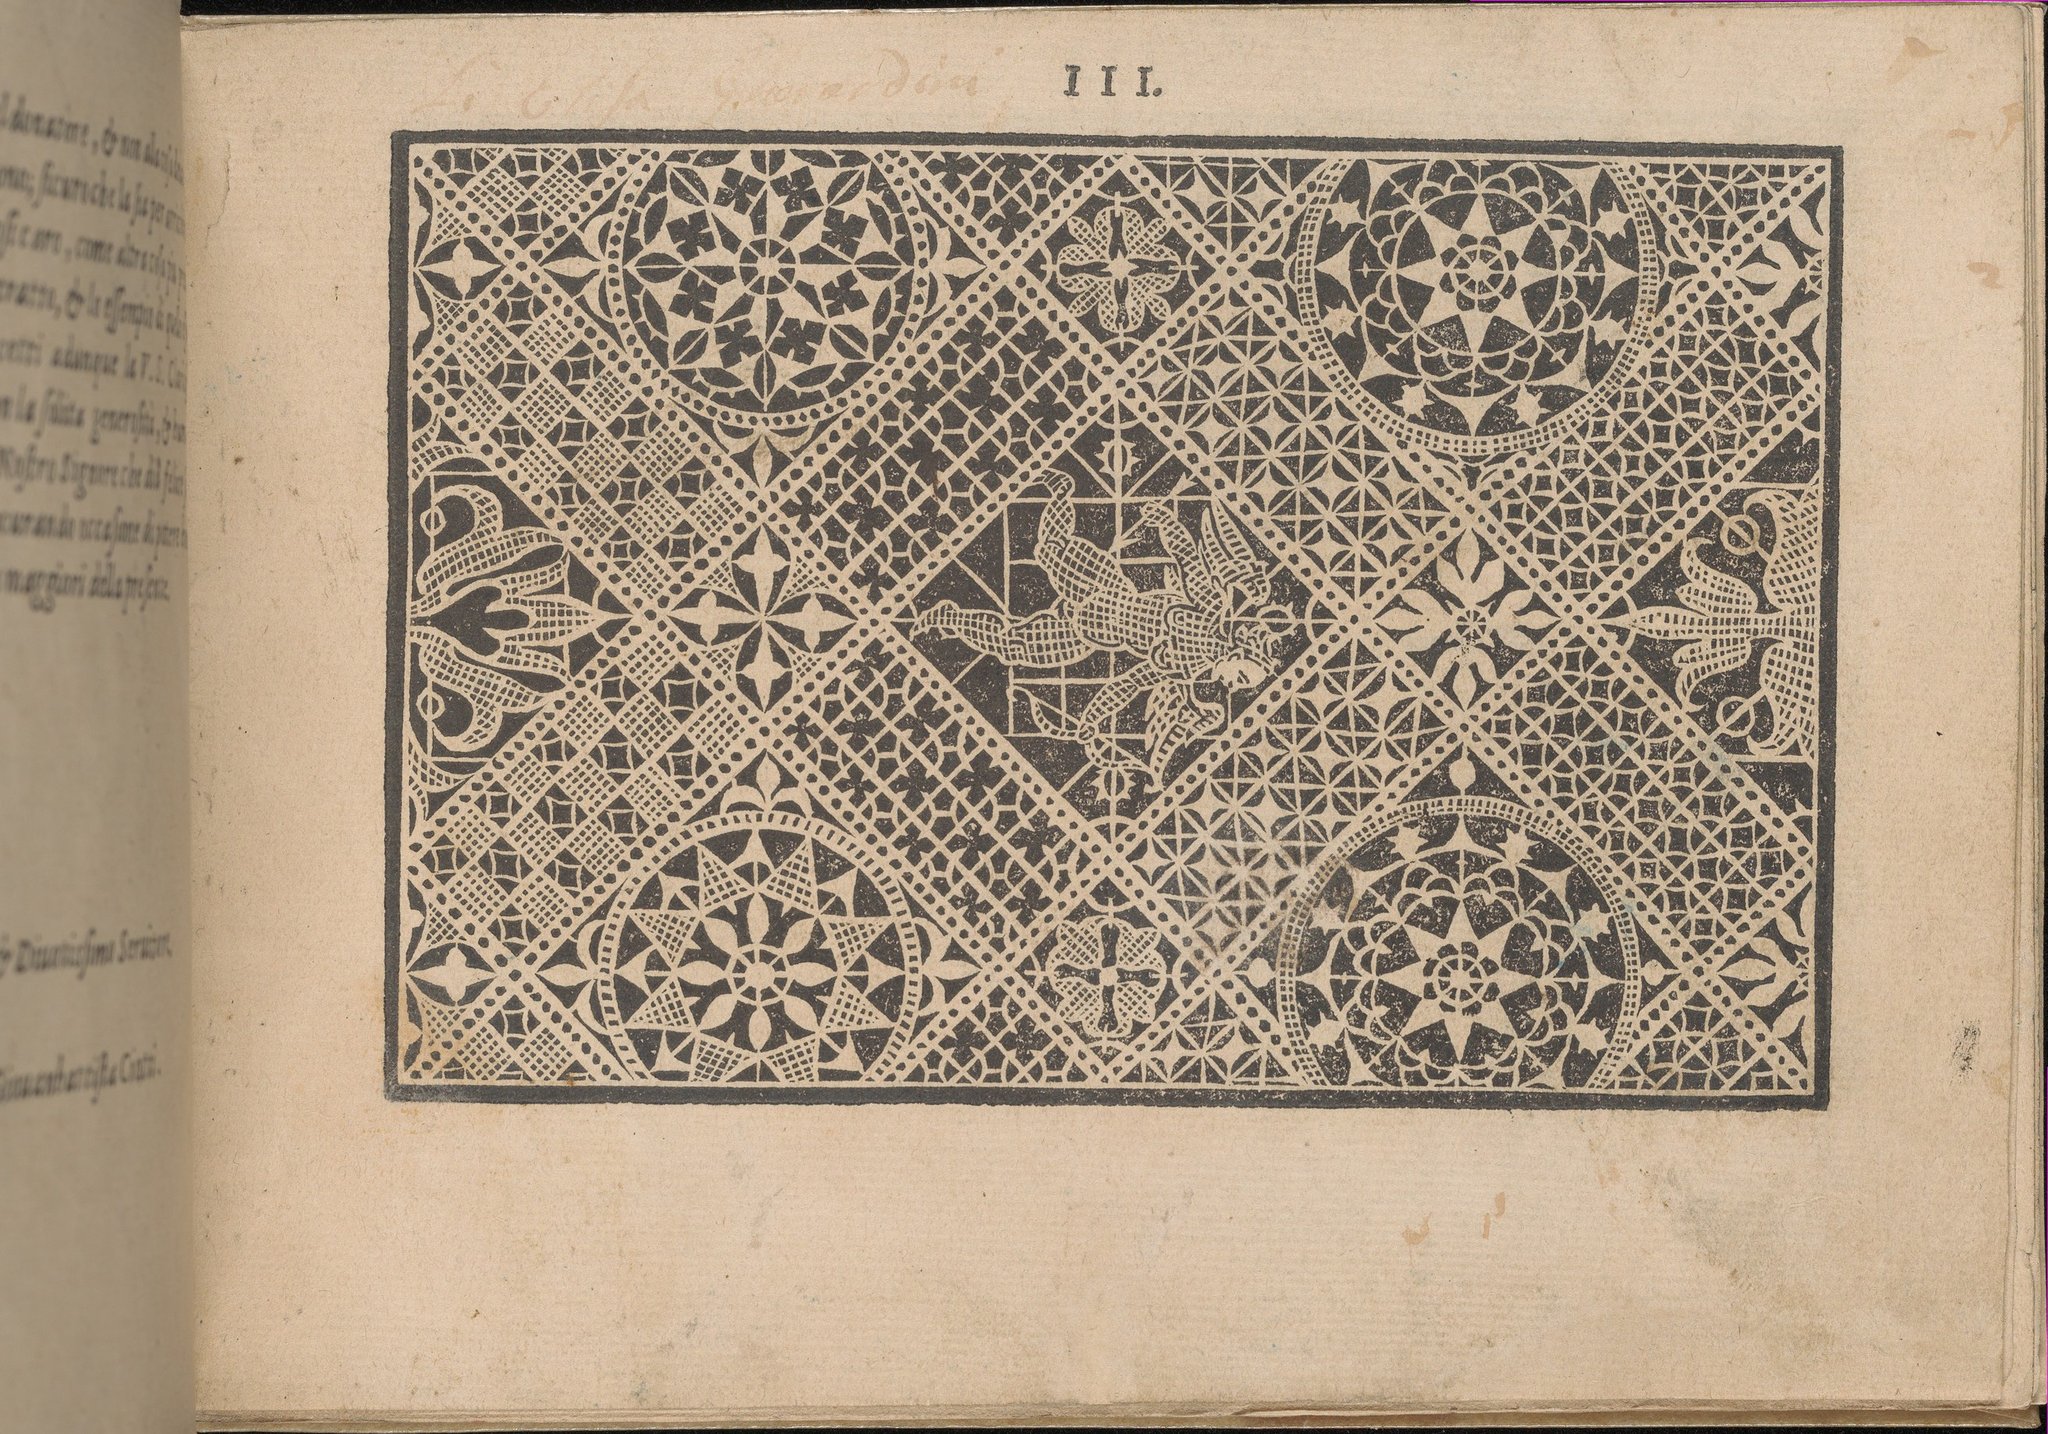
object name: book print ornament architecture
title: Prima Parte de' Fiori, e Disegni di varie sorti di Ricami Moderni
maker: giovanni battista ciotti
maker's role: author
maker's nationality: italian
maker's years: 1555-1659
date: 1591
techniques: woodcut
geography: italy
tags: flowers